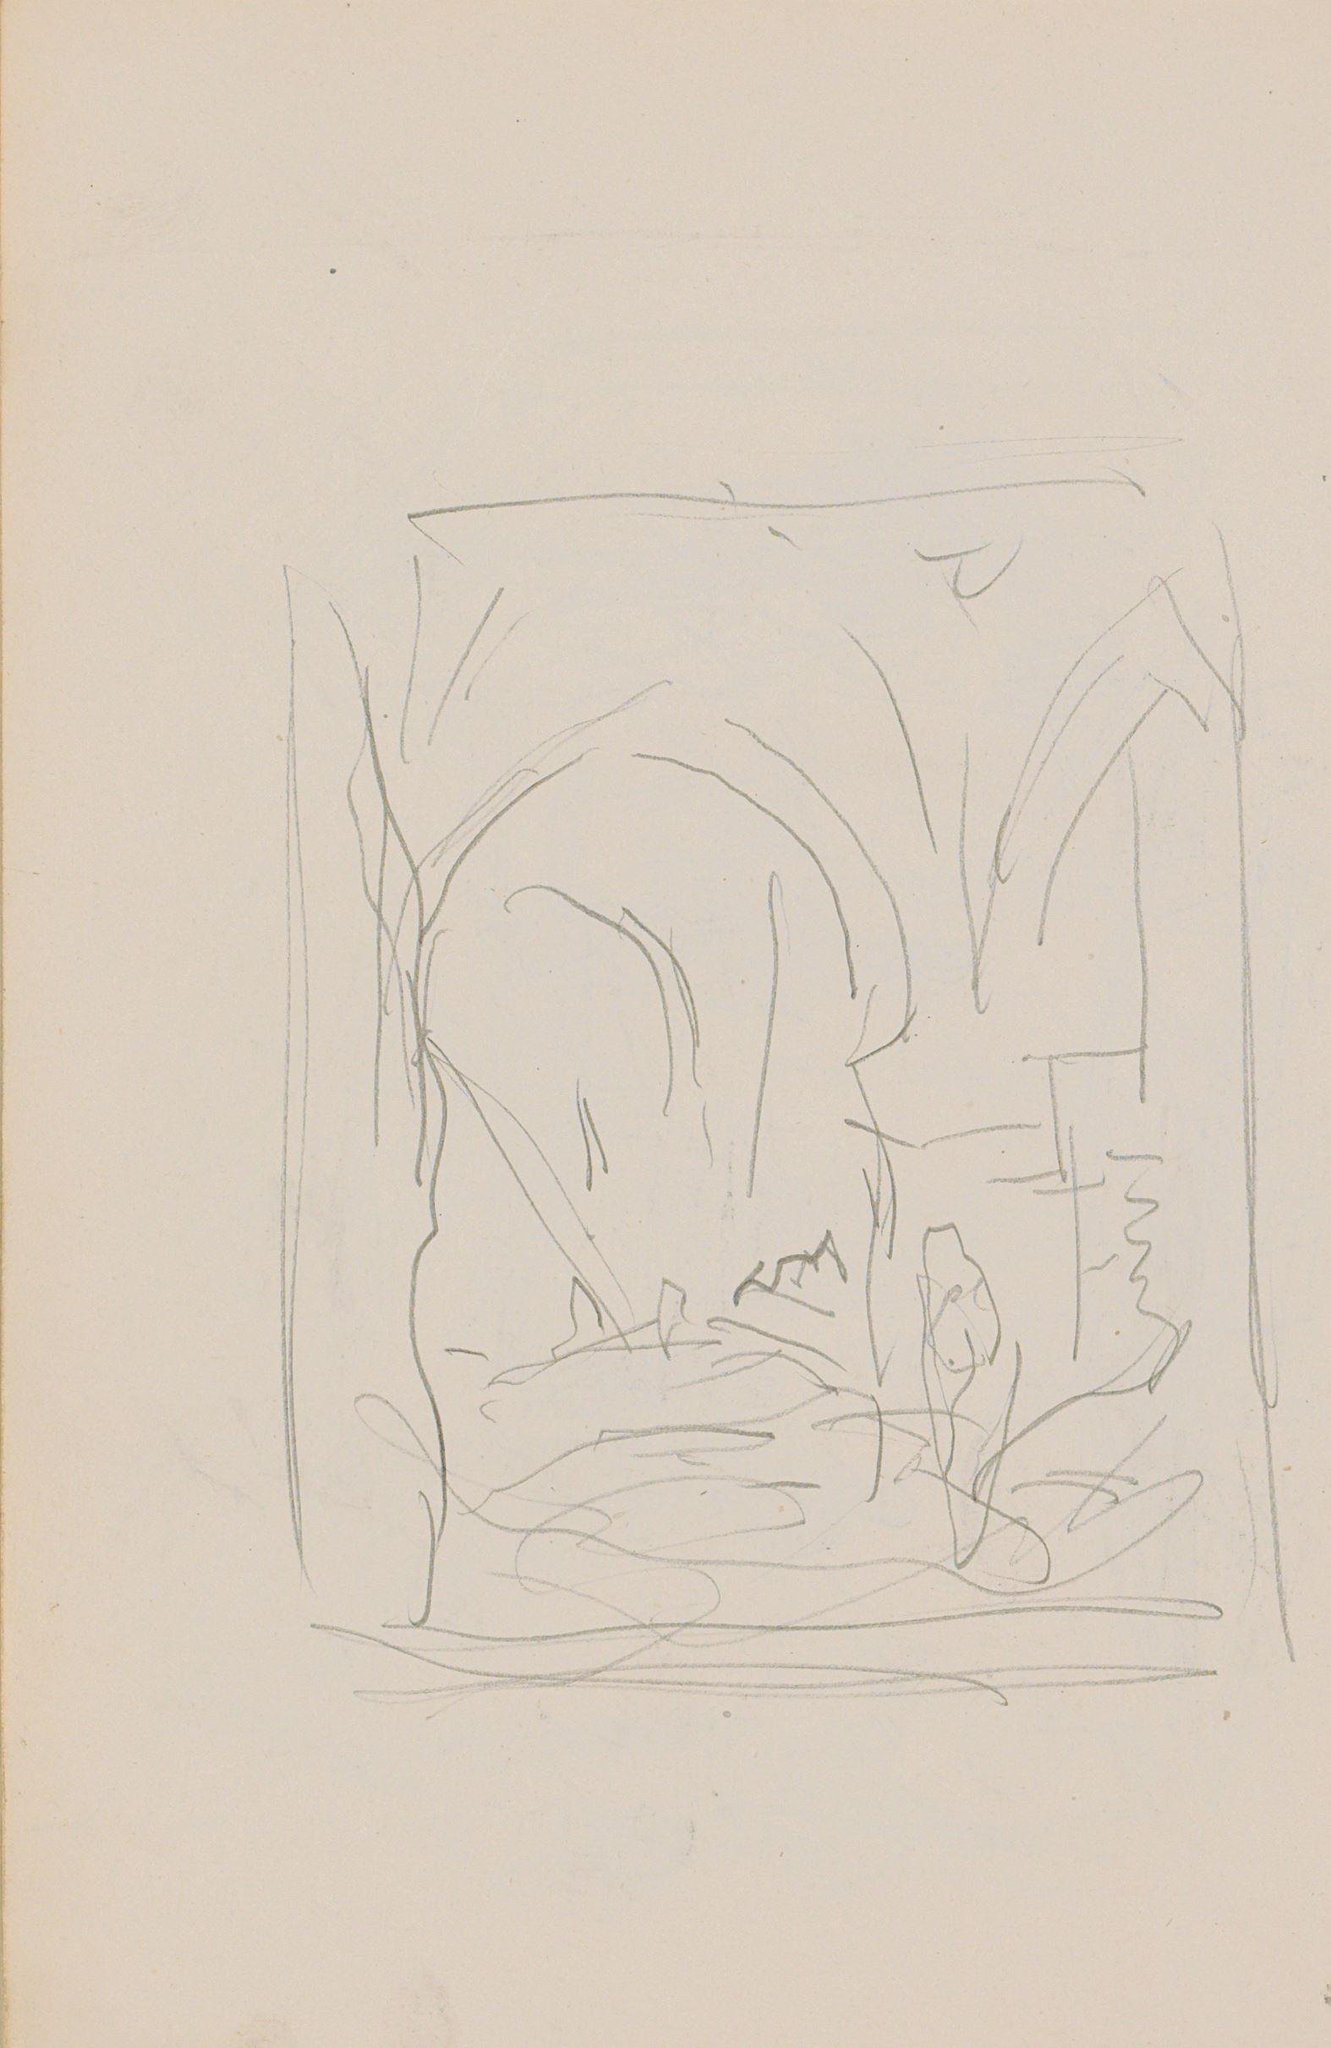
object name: sketchbook leaf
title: Spitsboogconstructie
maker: marius bauer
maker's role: draughtsman, print maker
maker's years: 1867-1932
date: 1923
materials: paper, pencil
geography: morocco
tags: arch, archivolt ~ architecture, architecture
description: Pagina 50 uit een schetsboek met 66 bladen.